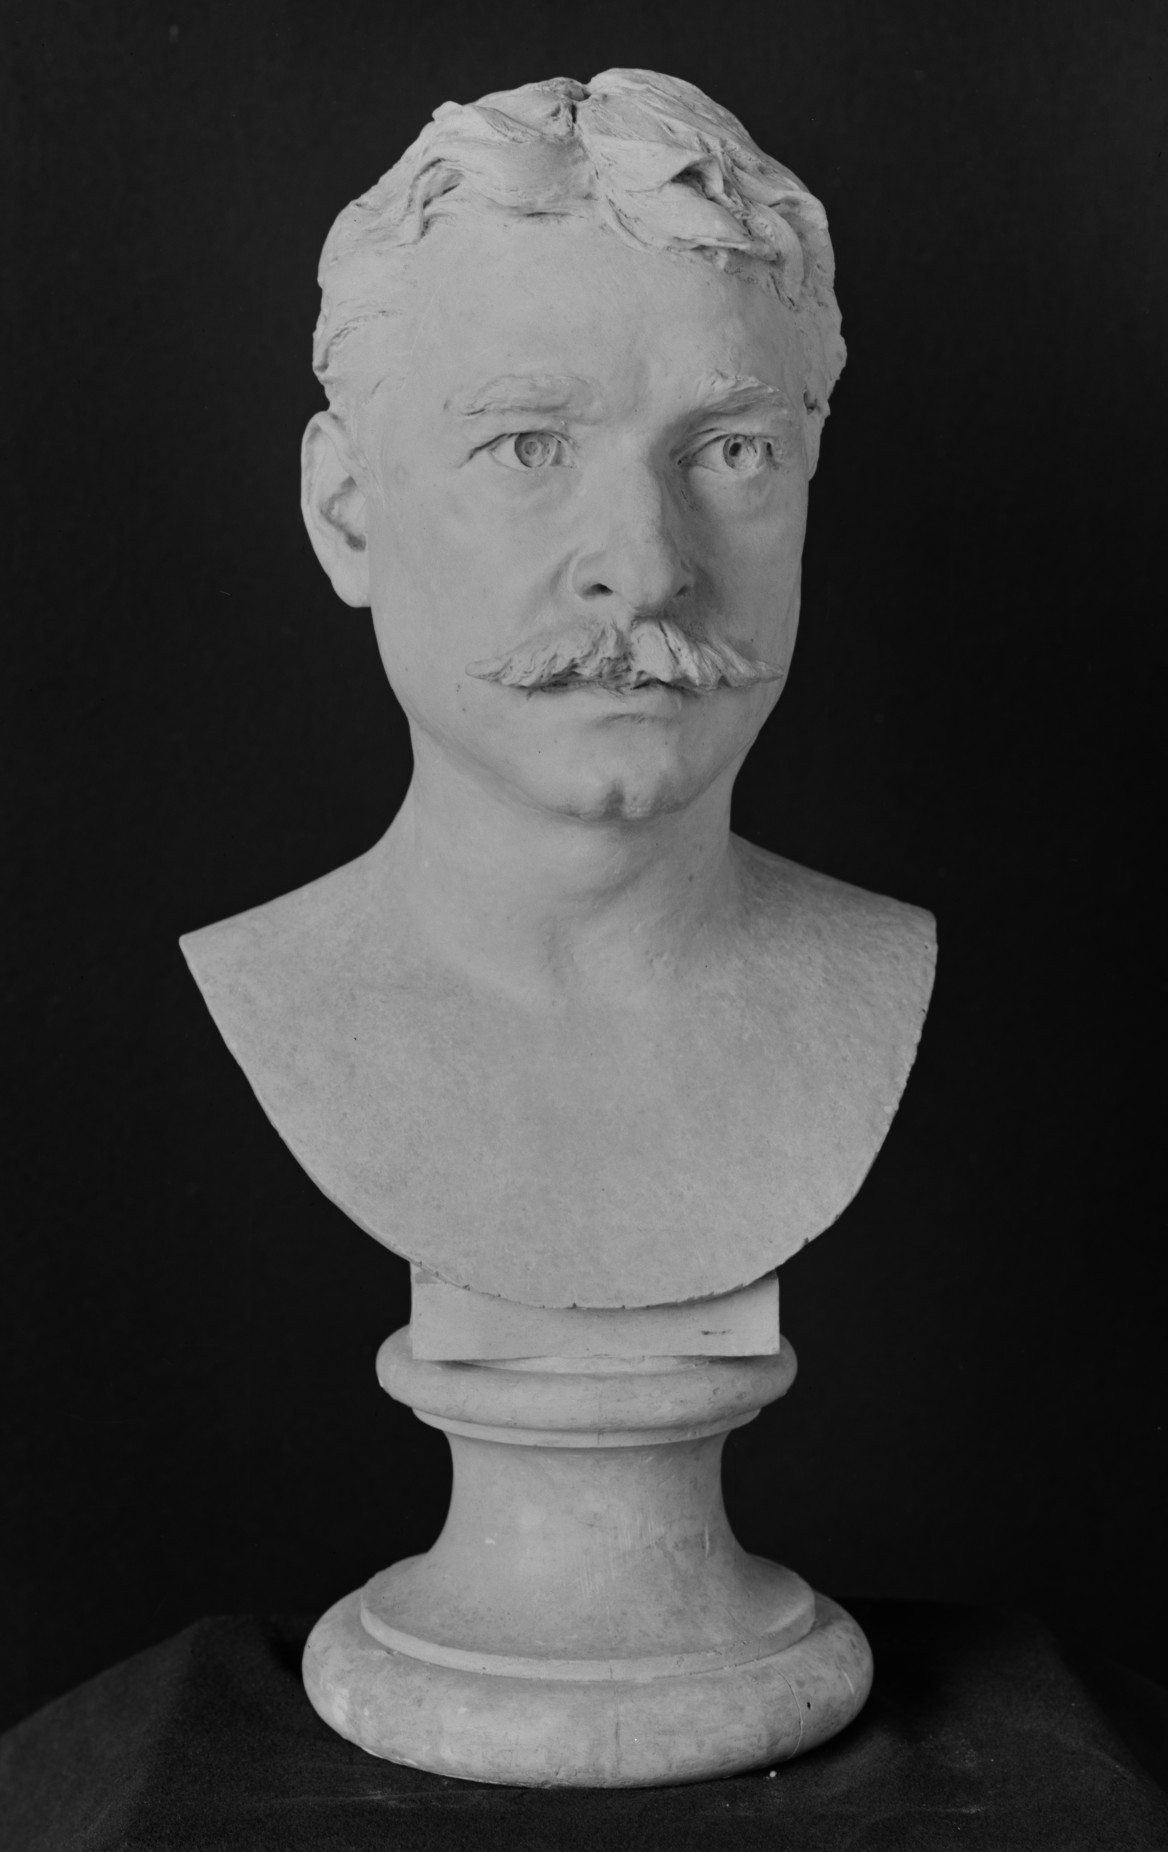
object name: bust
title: Paul Baudry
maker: paul dubois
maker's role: artist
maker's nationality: french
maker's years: 1829-1905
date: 1878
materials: plaster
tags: men,portraits